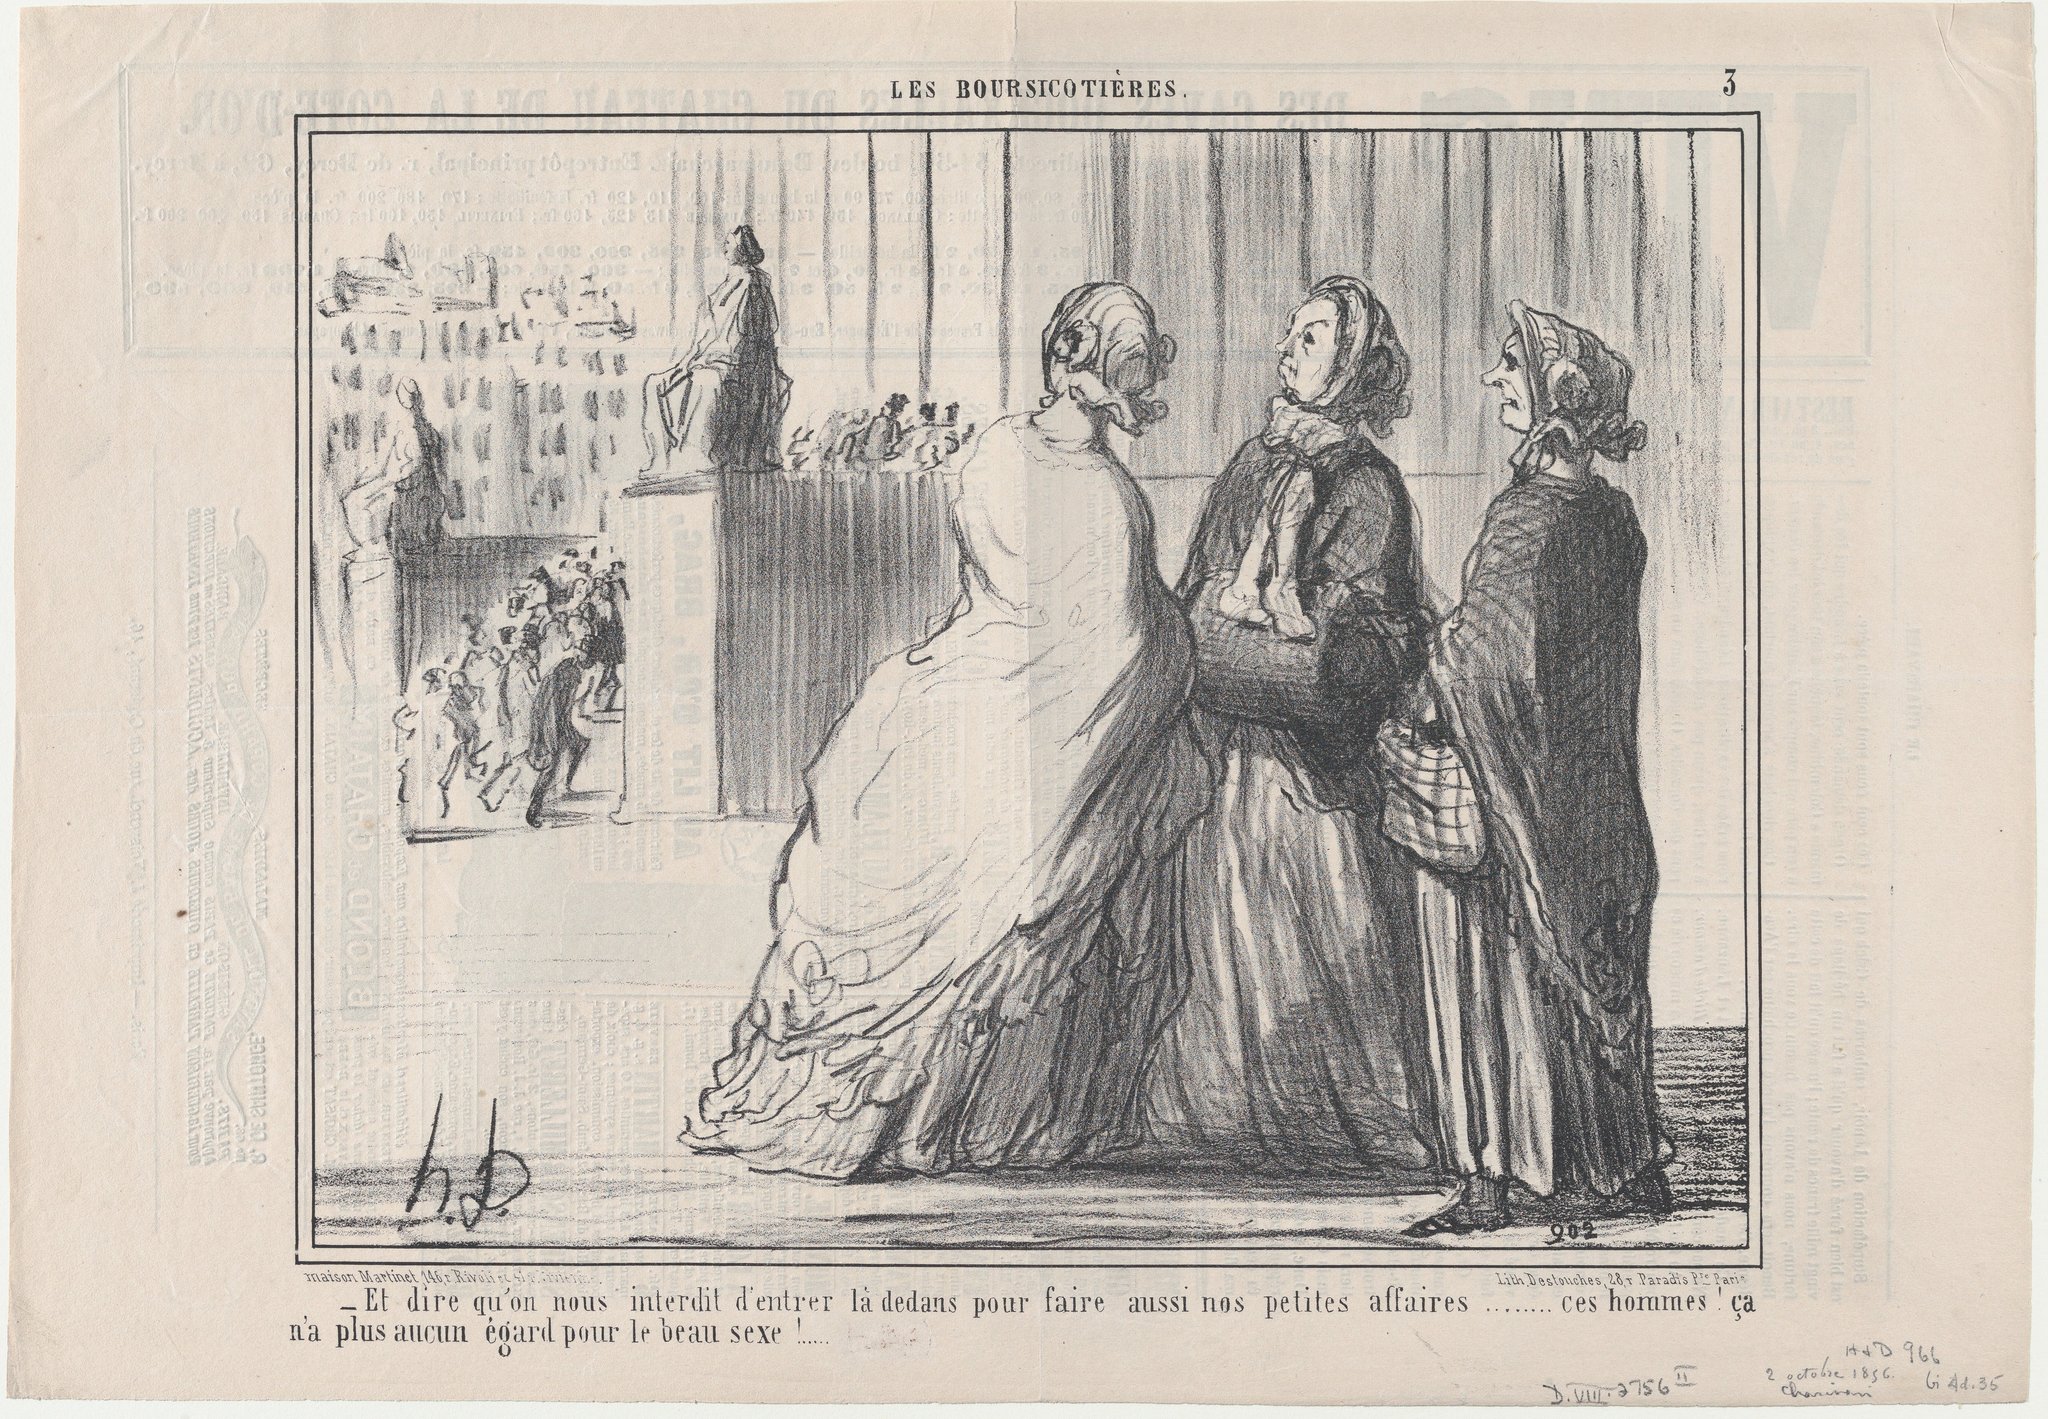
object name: print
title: Et dire qu'on nous interdit d'entrer..., from Les Boursicotières, published in Le Charivari, October 2, 1856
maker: honoré daumier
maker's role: artist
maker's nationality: french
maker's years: 1808-1879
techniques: lithograph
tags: women